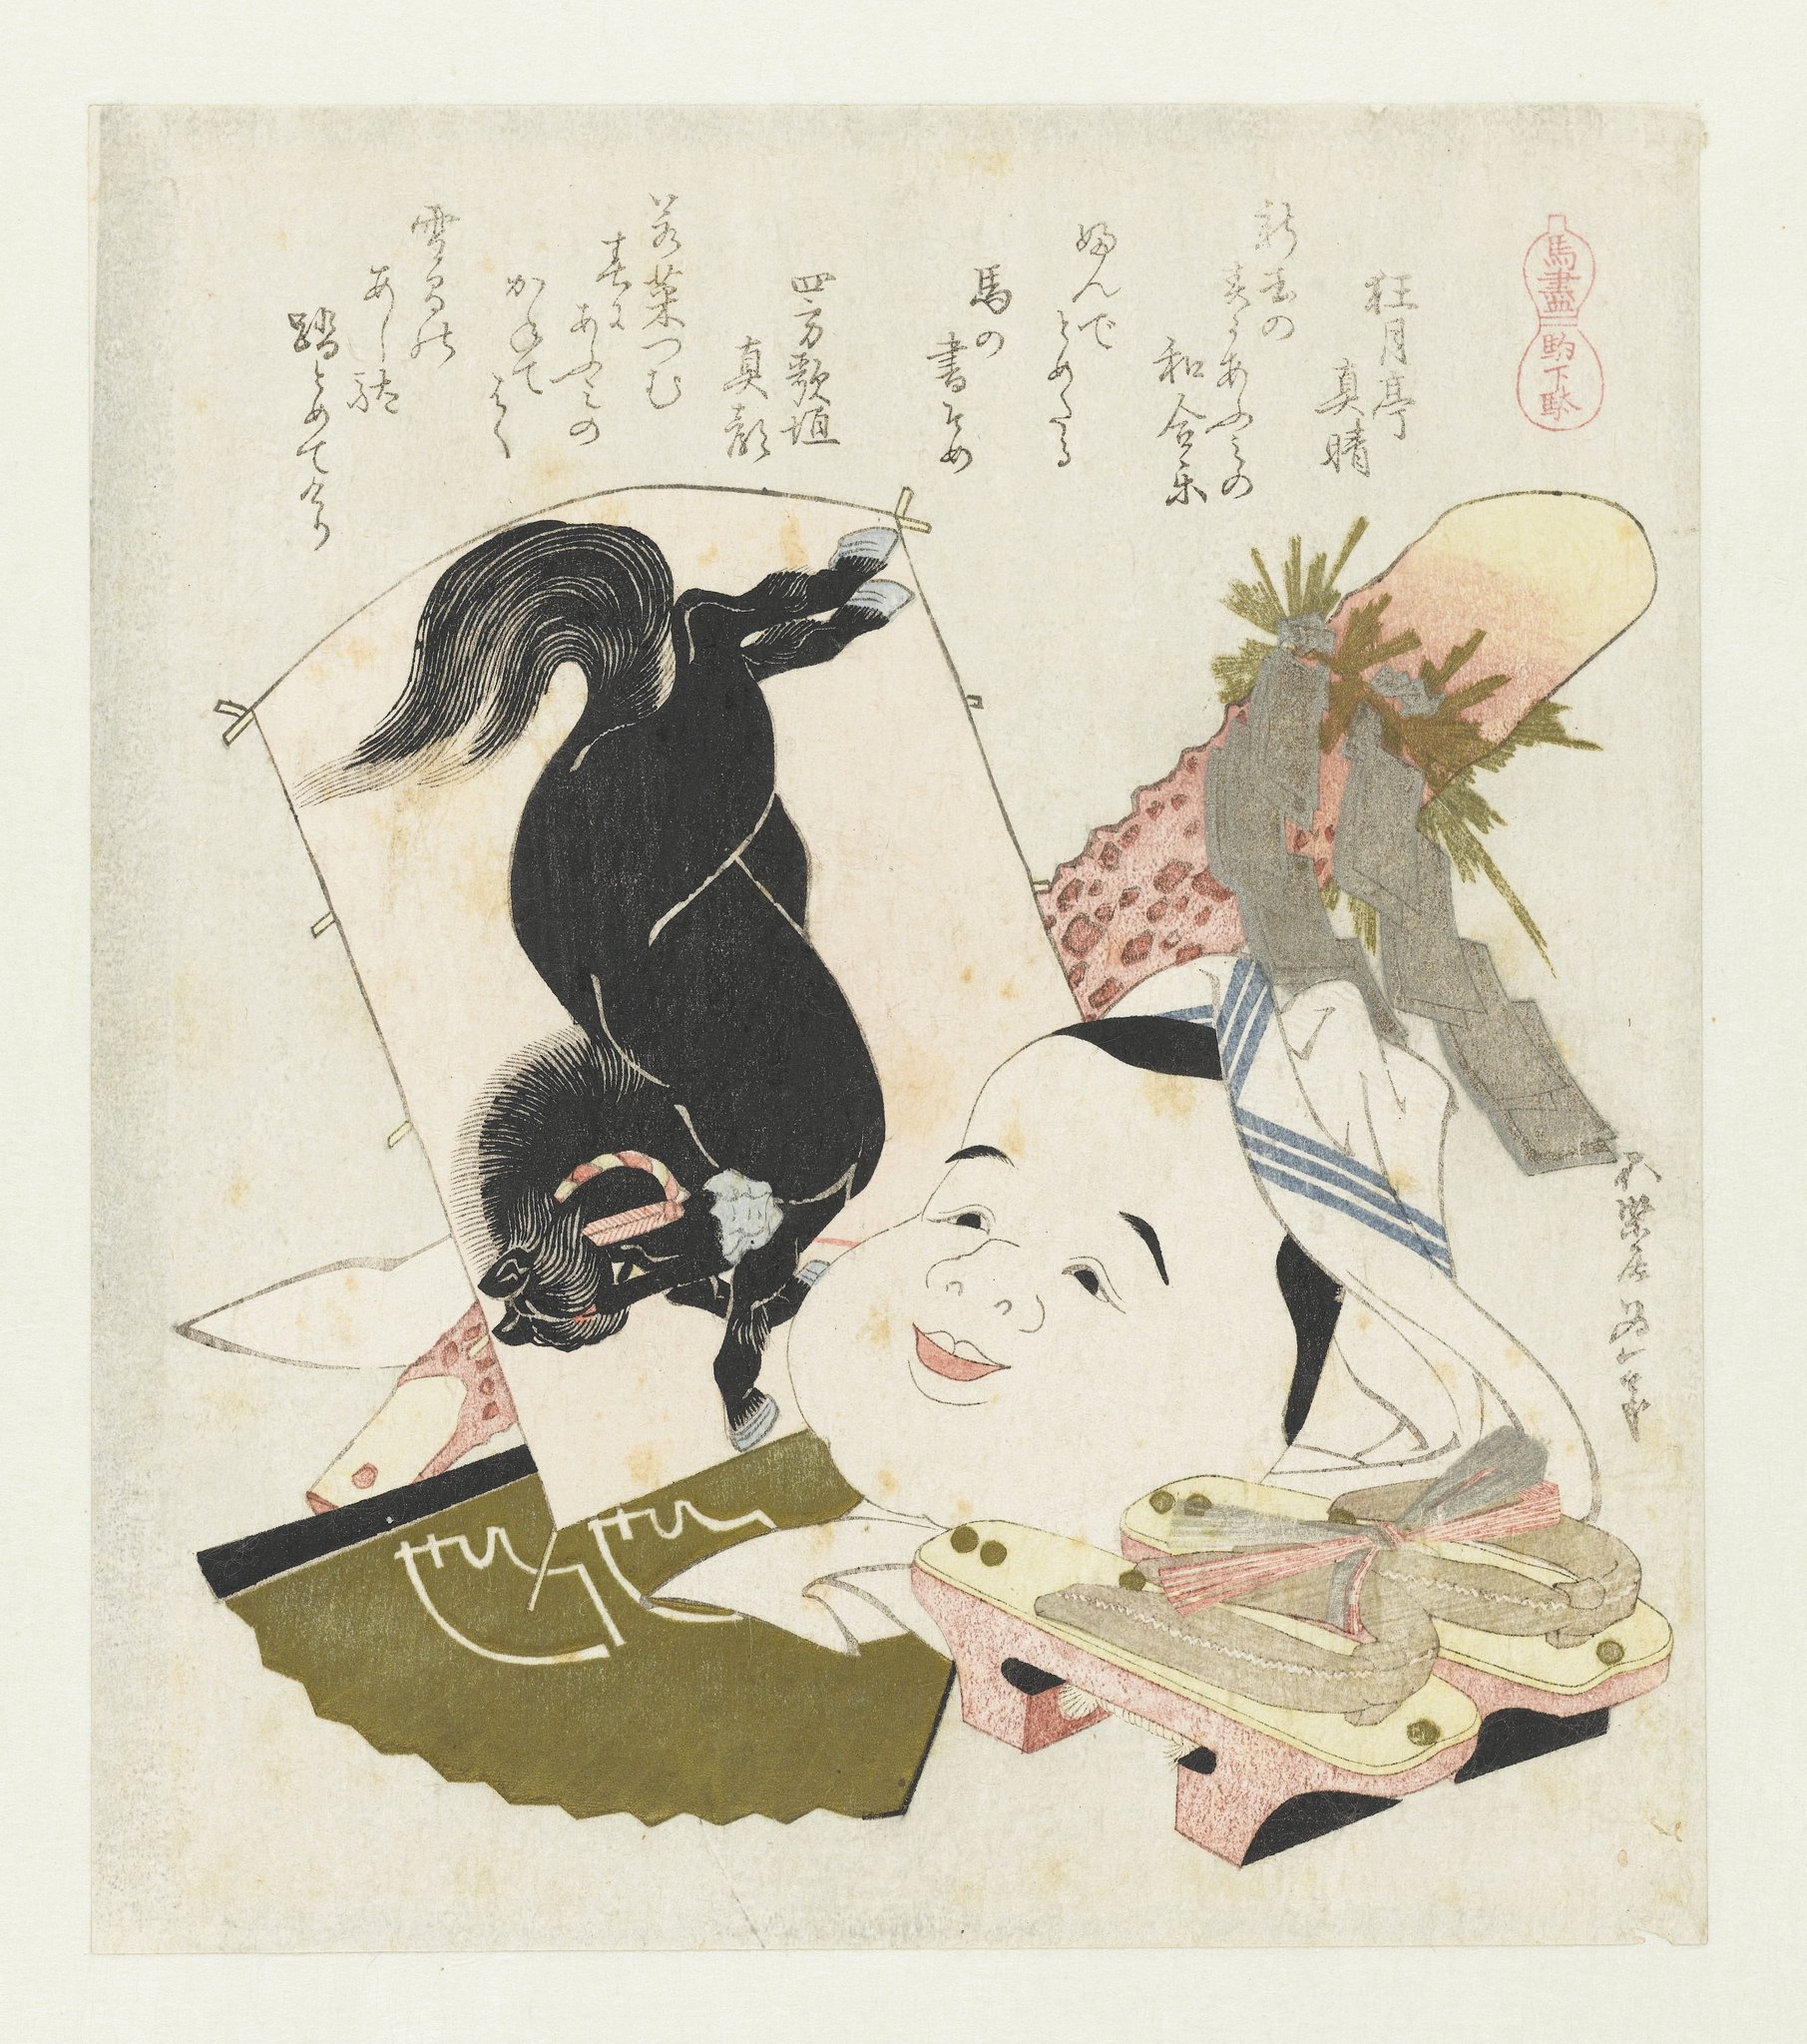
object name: surimono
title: Een serie met paarden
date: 1822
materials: paper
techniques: blind stamped, woodcut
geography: japan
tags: (flying a) kite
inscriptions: collector's mark, passe-partout, bottom left, printed: JABdH with a rooster., collector's mark, verso, stamped: Lugt 2228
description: Een stilleven van een Uzume masker, een vlieger met de afbeelding van een steigerend paard, een half geopende goudkleurige waaier, twee houten sandalen en een houten stamper met strookjes papier. Uzume is de godin van de voorspoed. De zogenaamde 'paarden-slippers' (komageta) worden uit één stuk hout gemaakt en gedragen door maiko en geisha. Met twee gedichten.